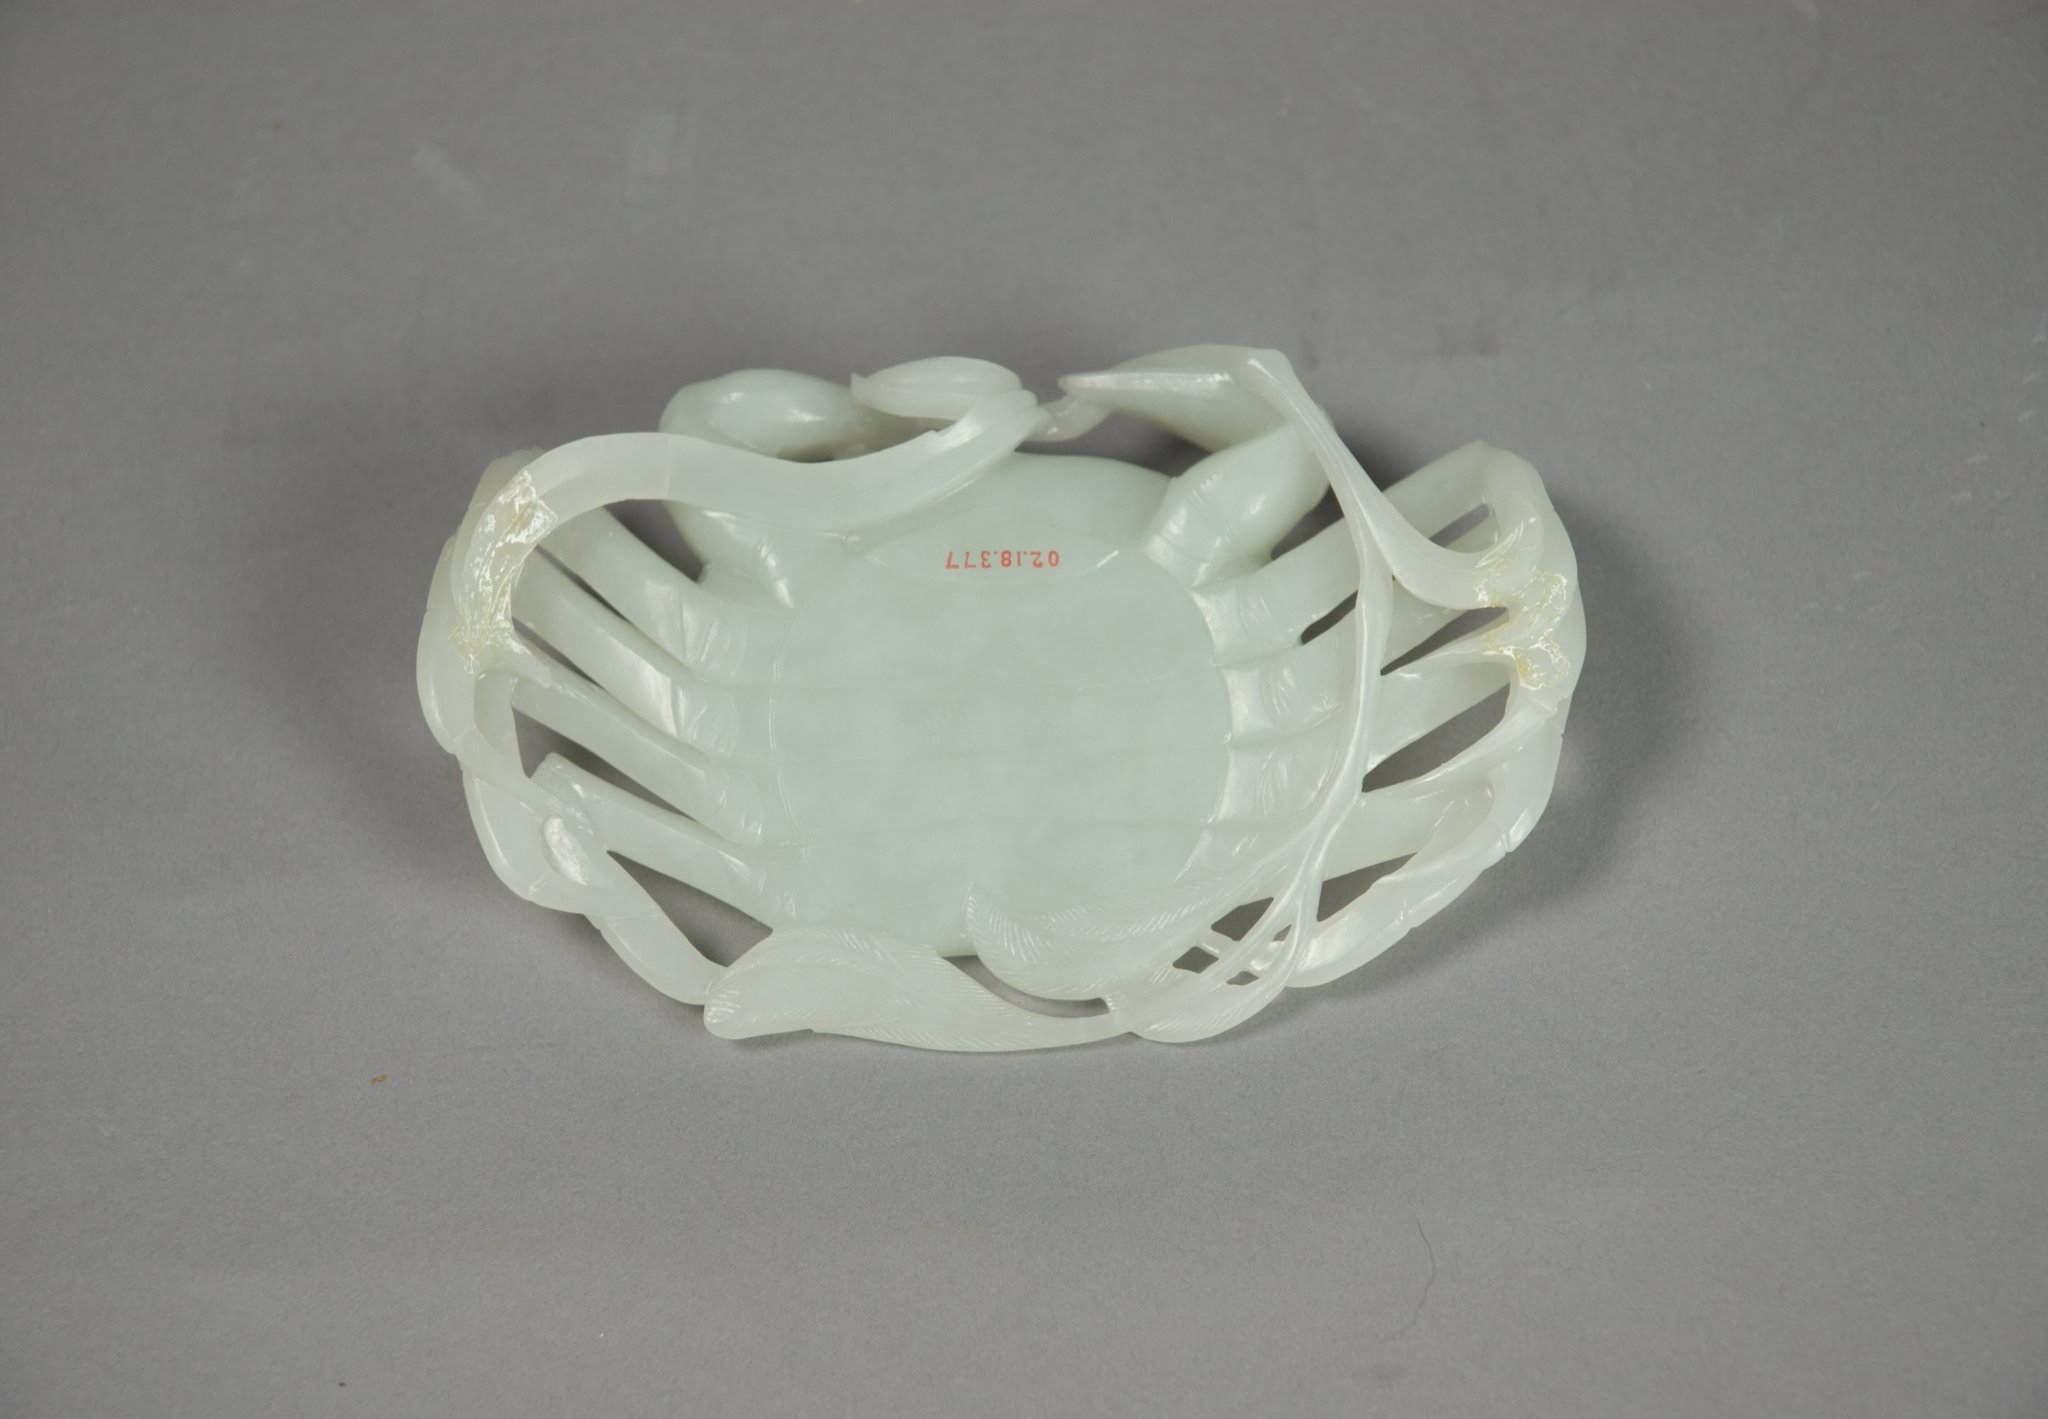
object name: figure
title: Crab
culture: chinese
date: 1701-1800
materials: jade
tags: crabs